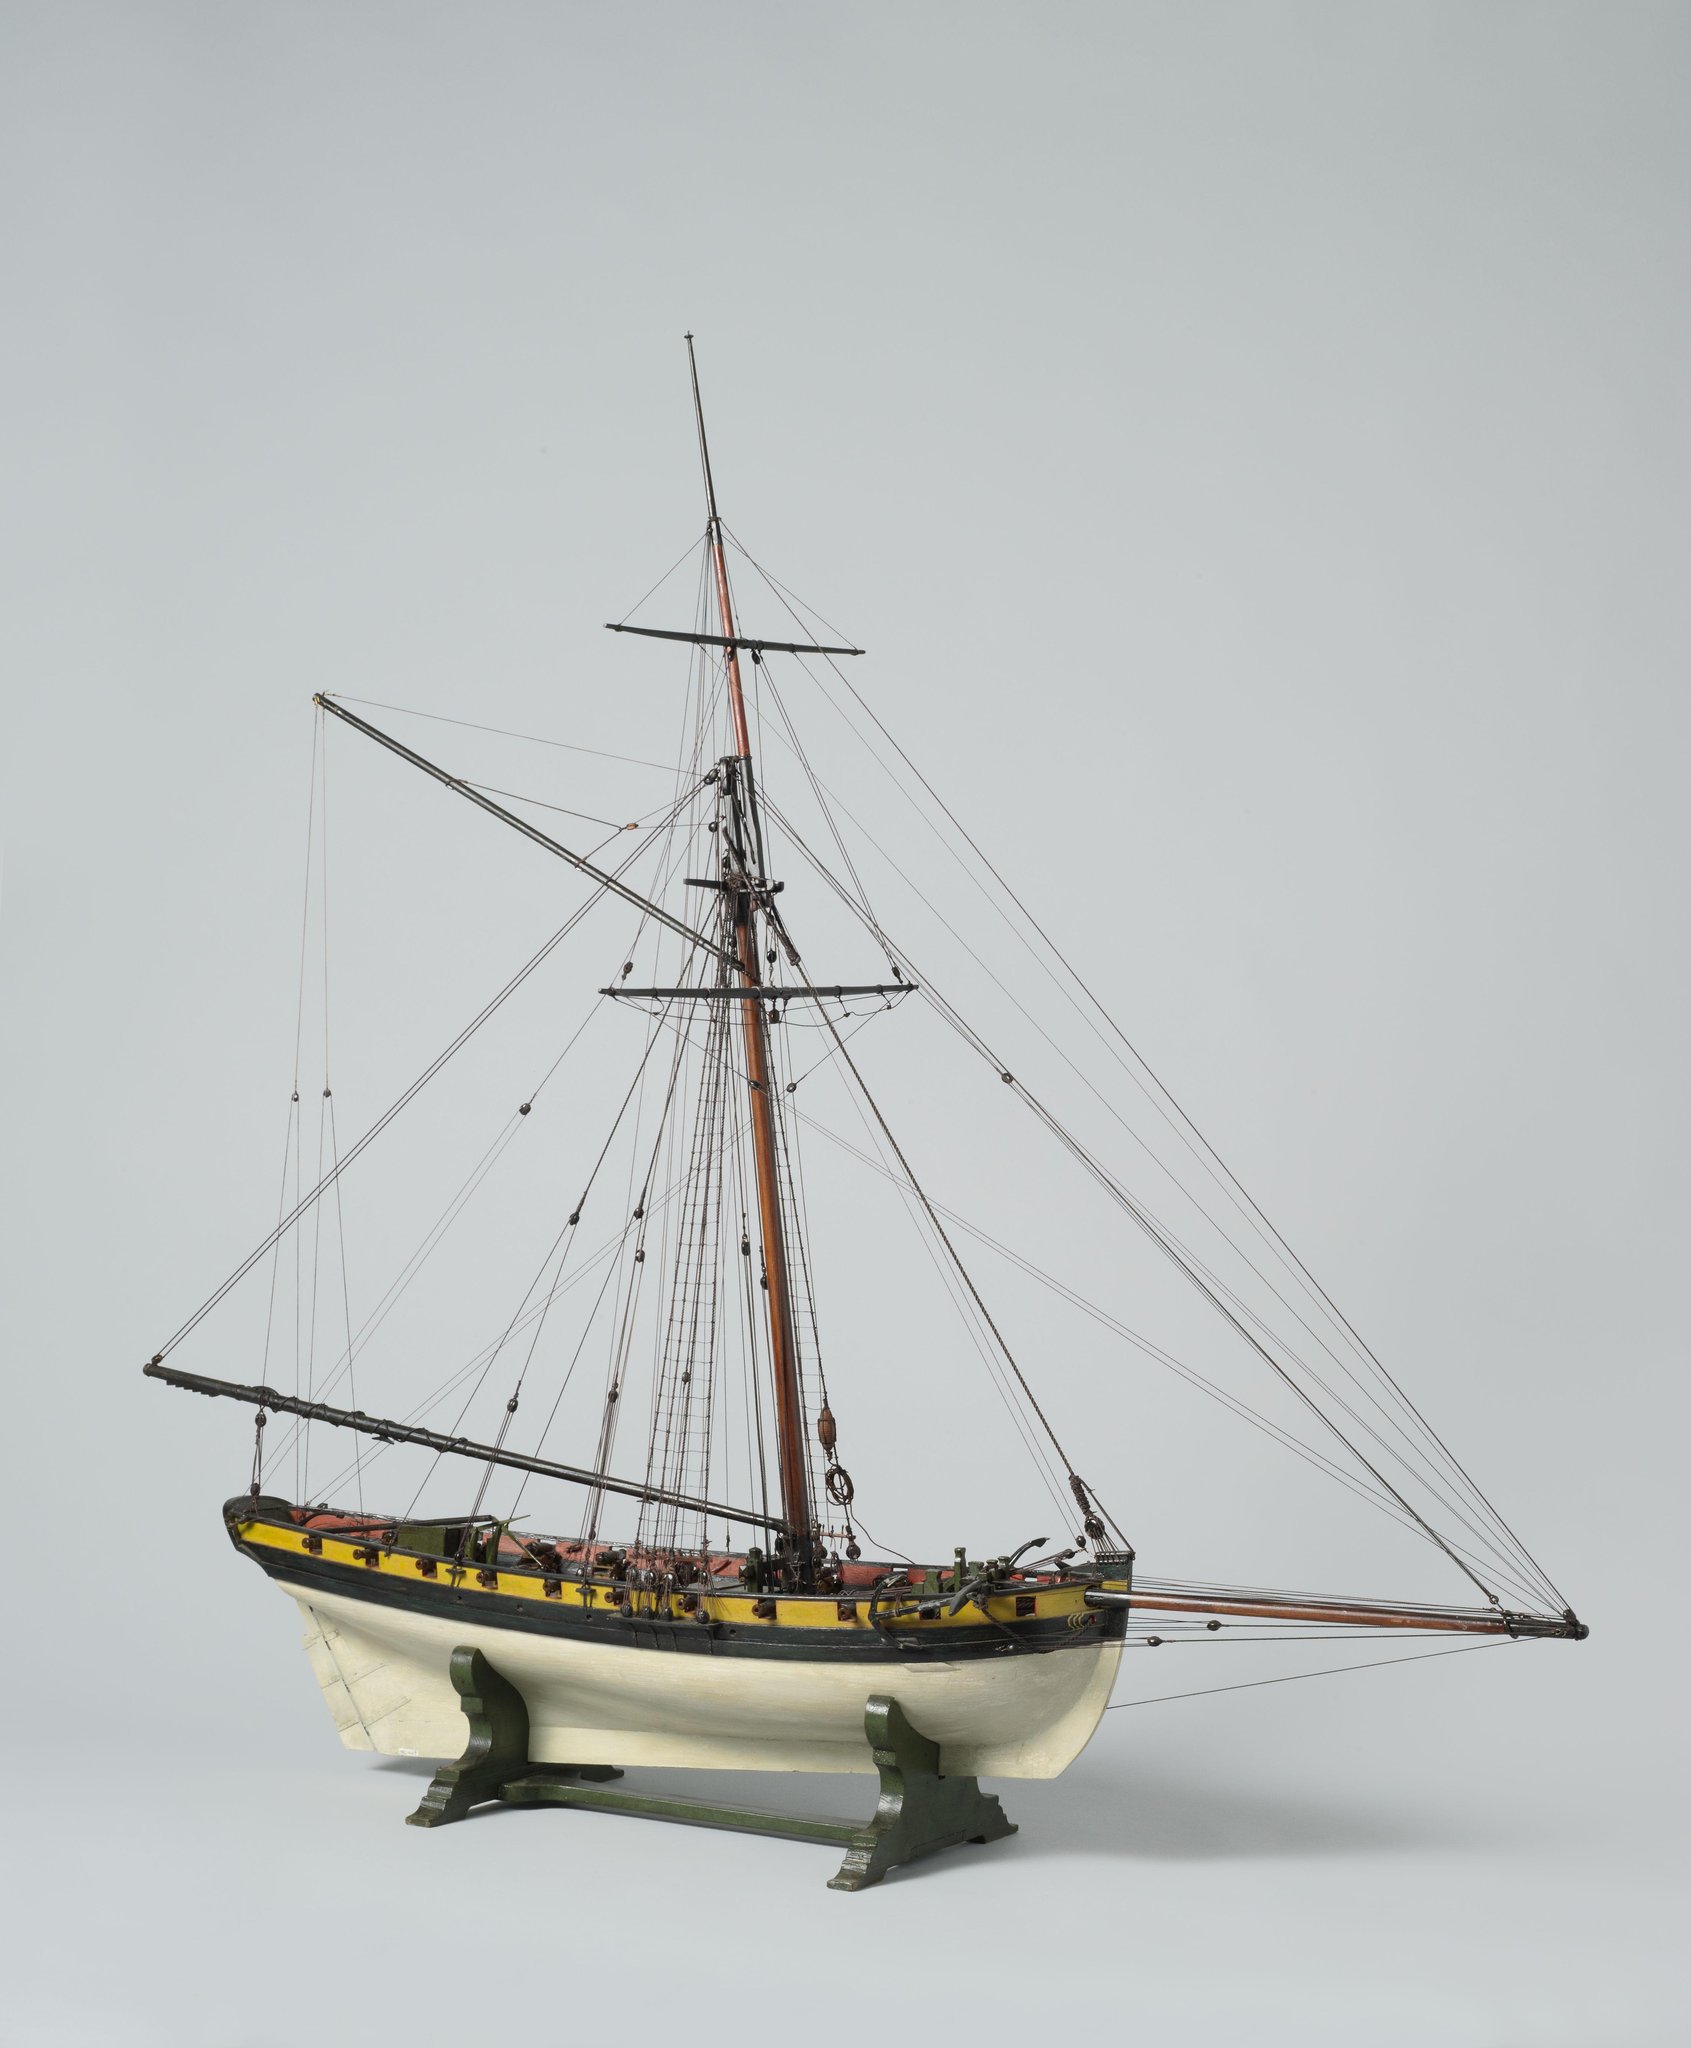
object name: show model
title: Model of a 20-Gun Cutter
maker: Anonymous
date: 1775-1800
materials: brass, bronze, iron, fiber, textile, wood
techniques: polychromy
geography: netherlands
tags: ship-model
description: Gepolychromeerd, getuigd blokmodel van een kotter van 20 stukken. Het heeft achttien stukken (twee ontbreken) op het open dek. De voorsteven is gebogen. Platte spiegel, hol wulf polychroom beschilderd met draperieën, gesloten hek polychroom beschilderd met zittende vrouw met anker voor zee met schip; recht roer met vierkante roerkoning en helmstok aan dek, sterk vallende achtersteven. De zeeg komt iets op naar beide uiteinden, één barkhout. Het onderwaterschip is een scherp gepiekt rondspant met grote stuurlast. Het model is voorzien van twee ankers, een braadspil, twee pompen en verschillende luiken. Het tuig is een eenmast gaffeltuig en heeft een breefok.